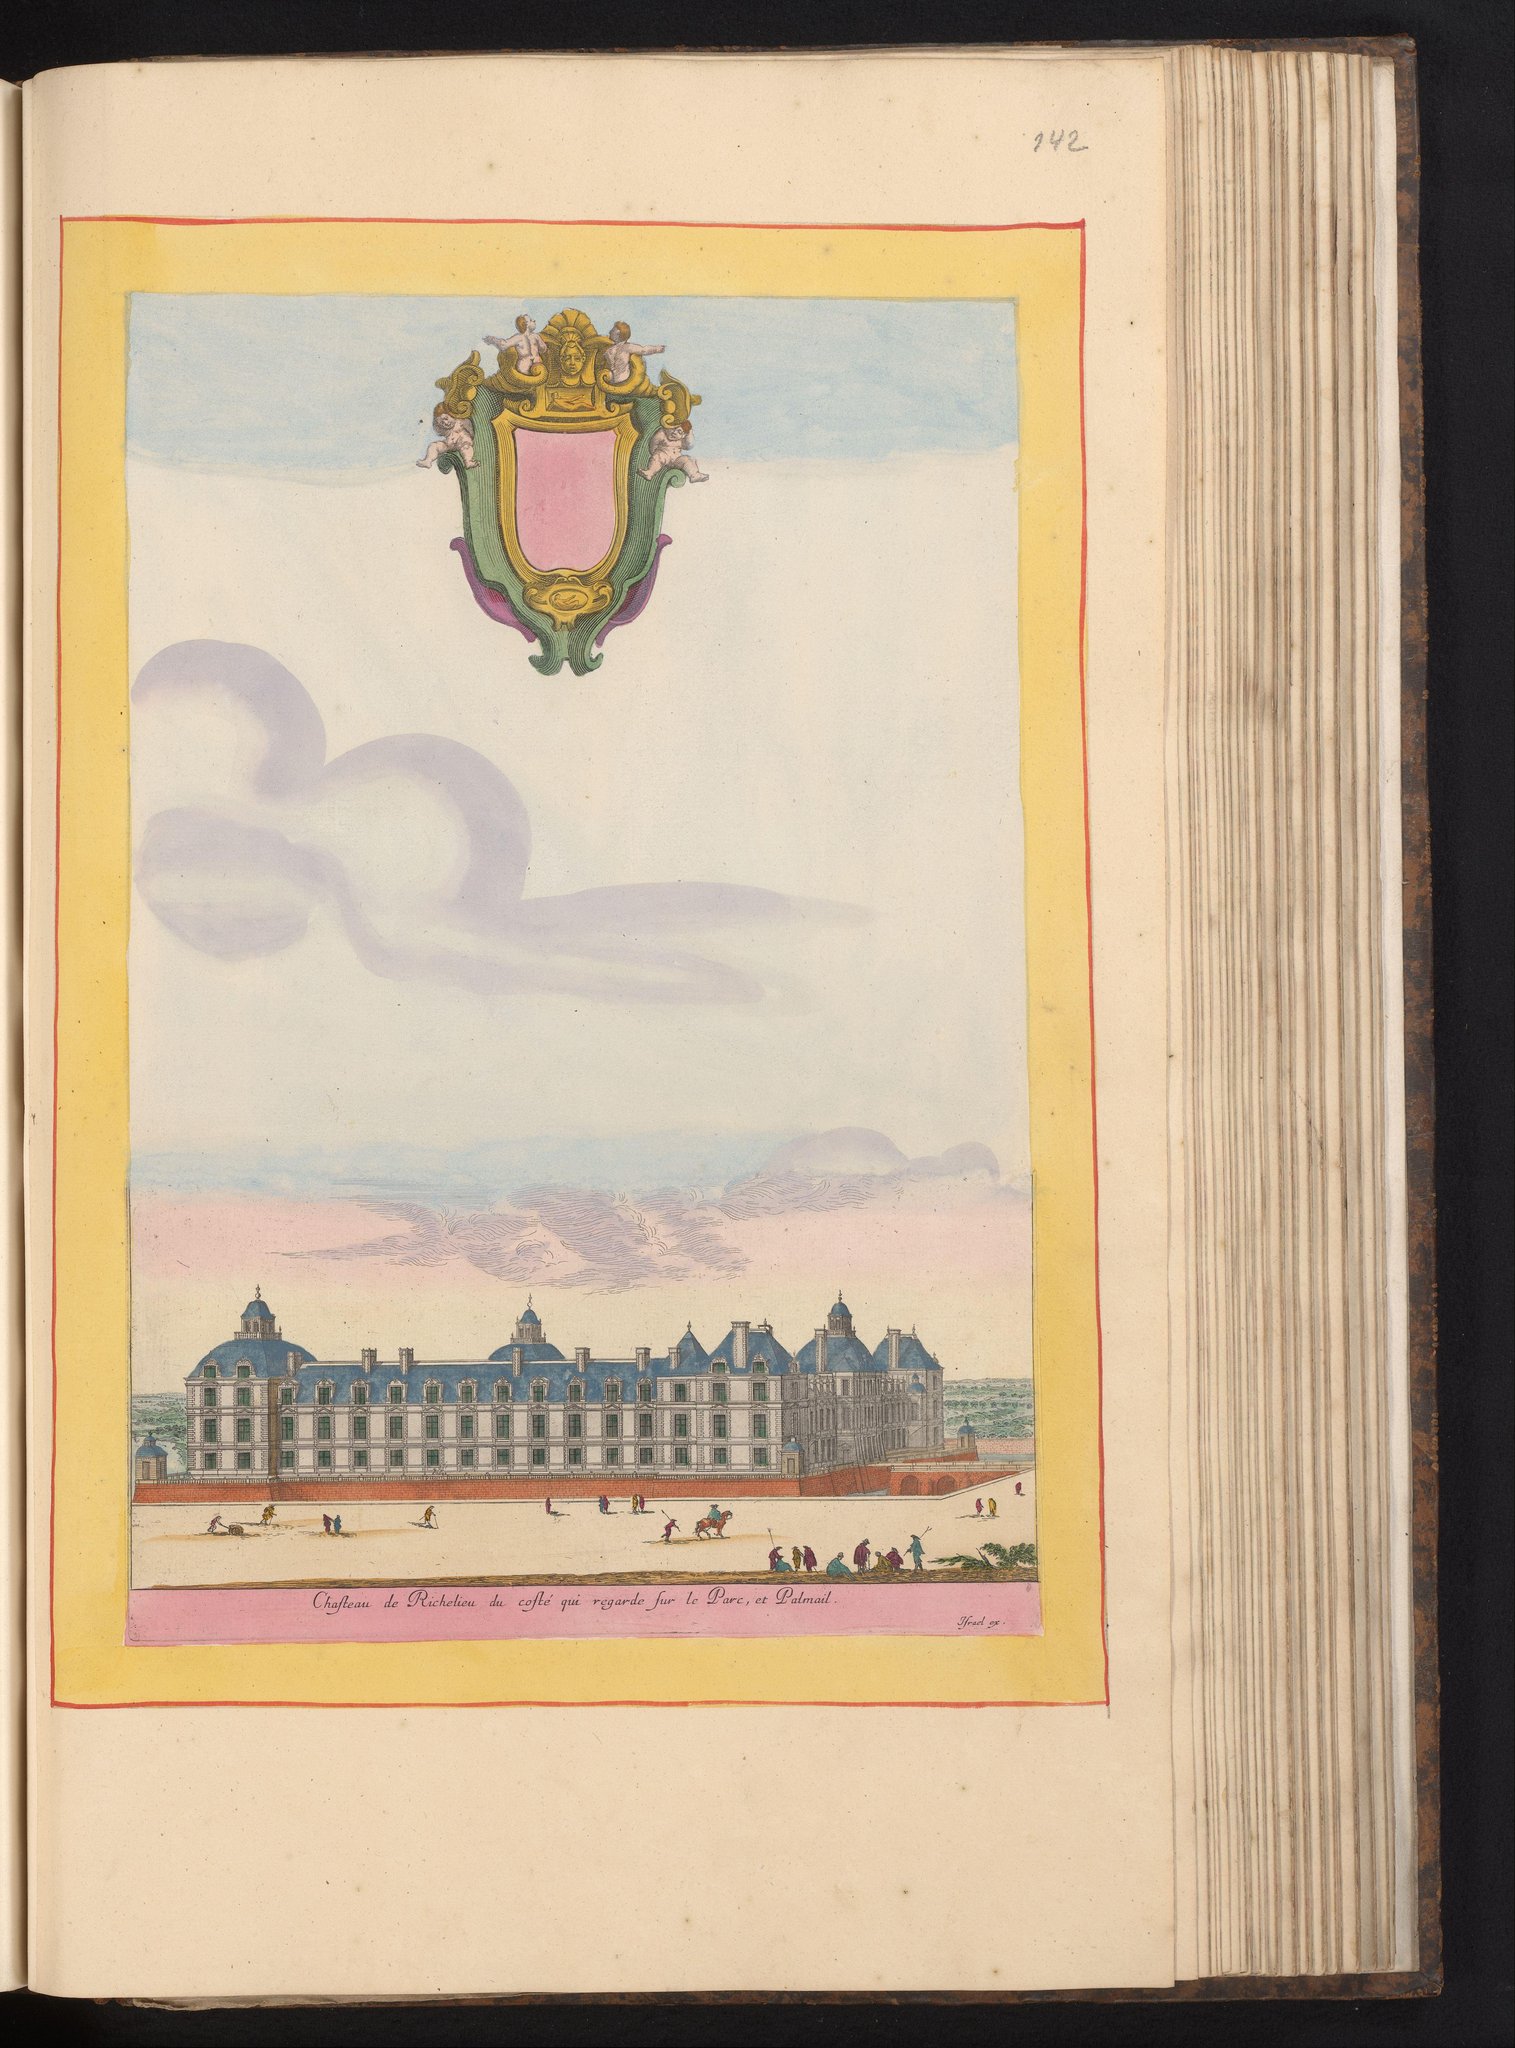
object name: print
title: Chasteau de Richelieu du costé qui regarde sur le parc, et Palmail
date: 1649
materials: paper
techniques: engraving, etching, hand coloring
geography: paris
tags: castle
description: Uit een serie van twaalf ongenummerde prenten.